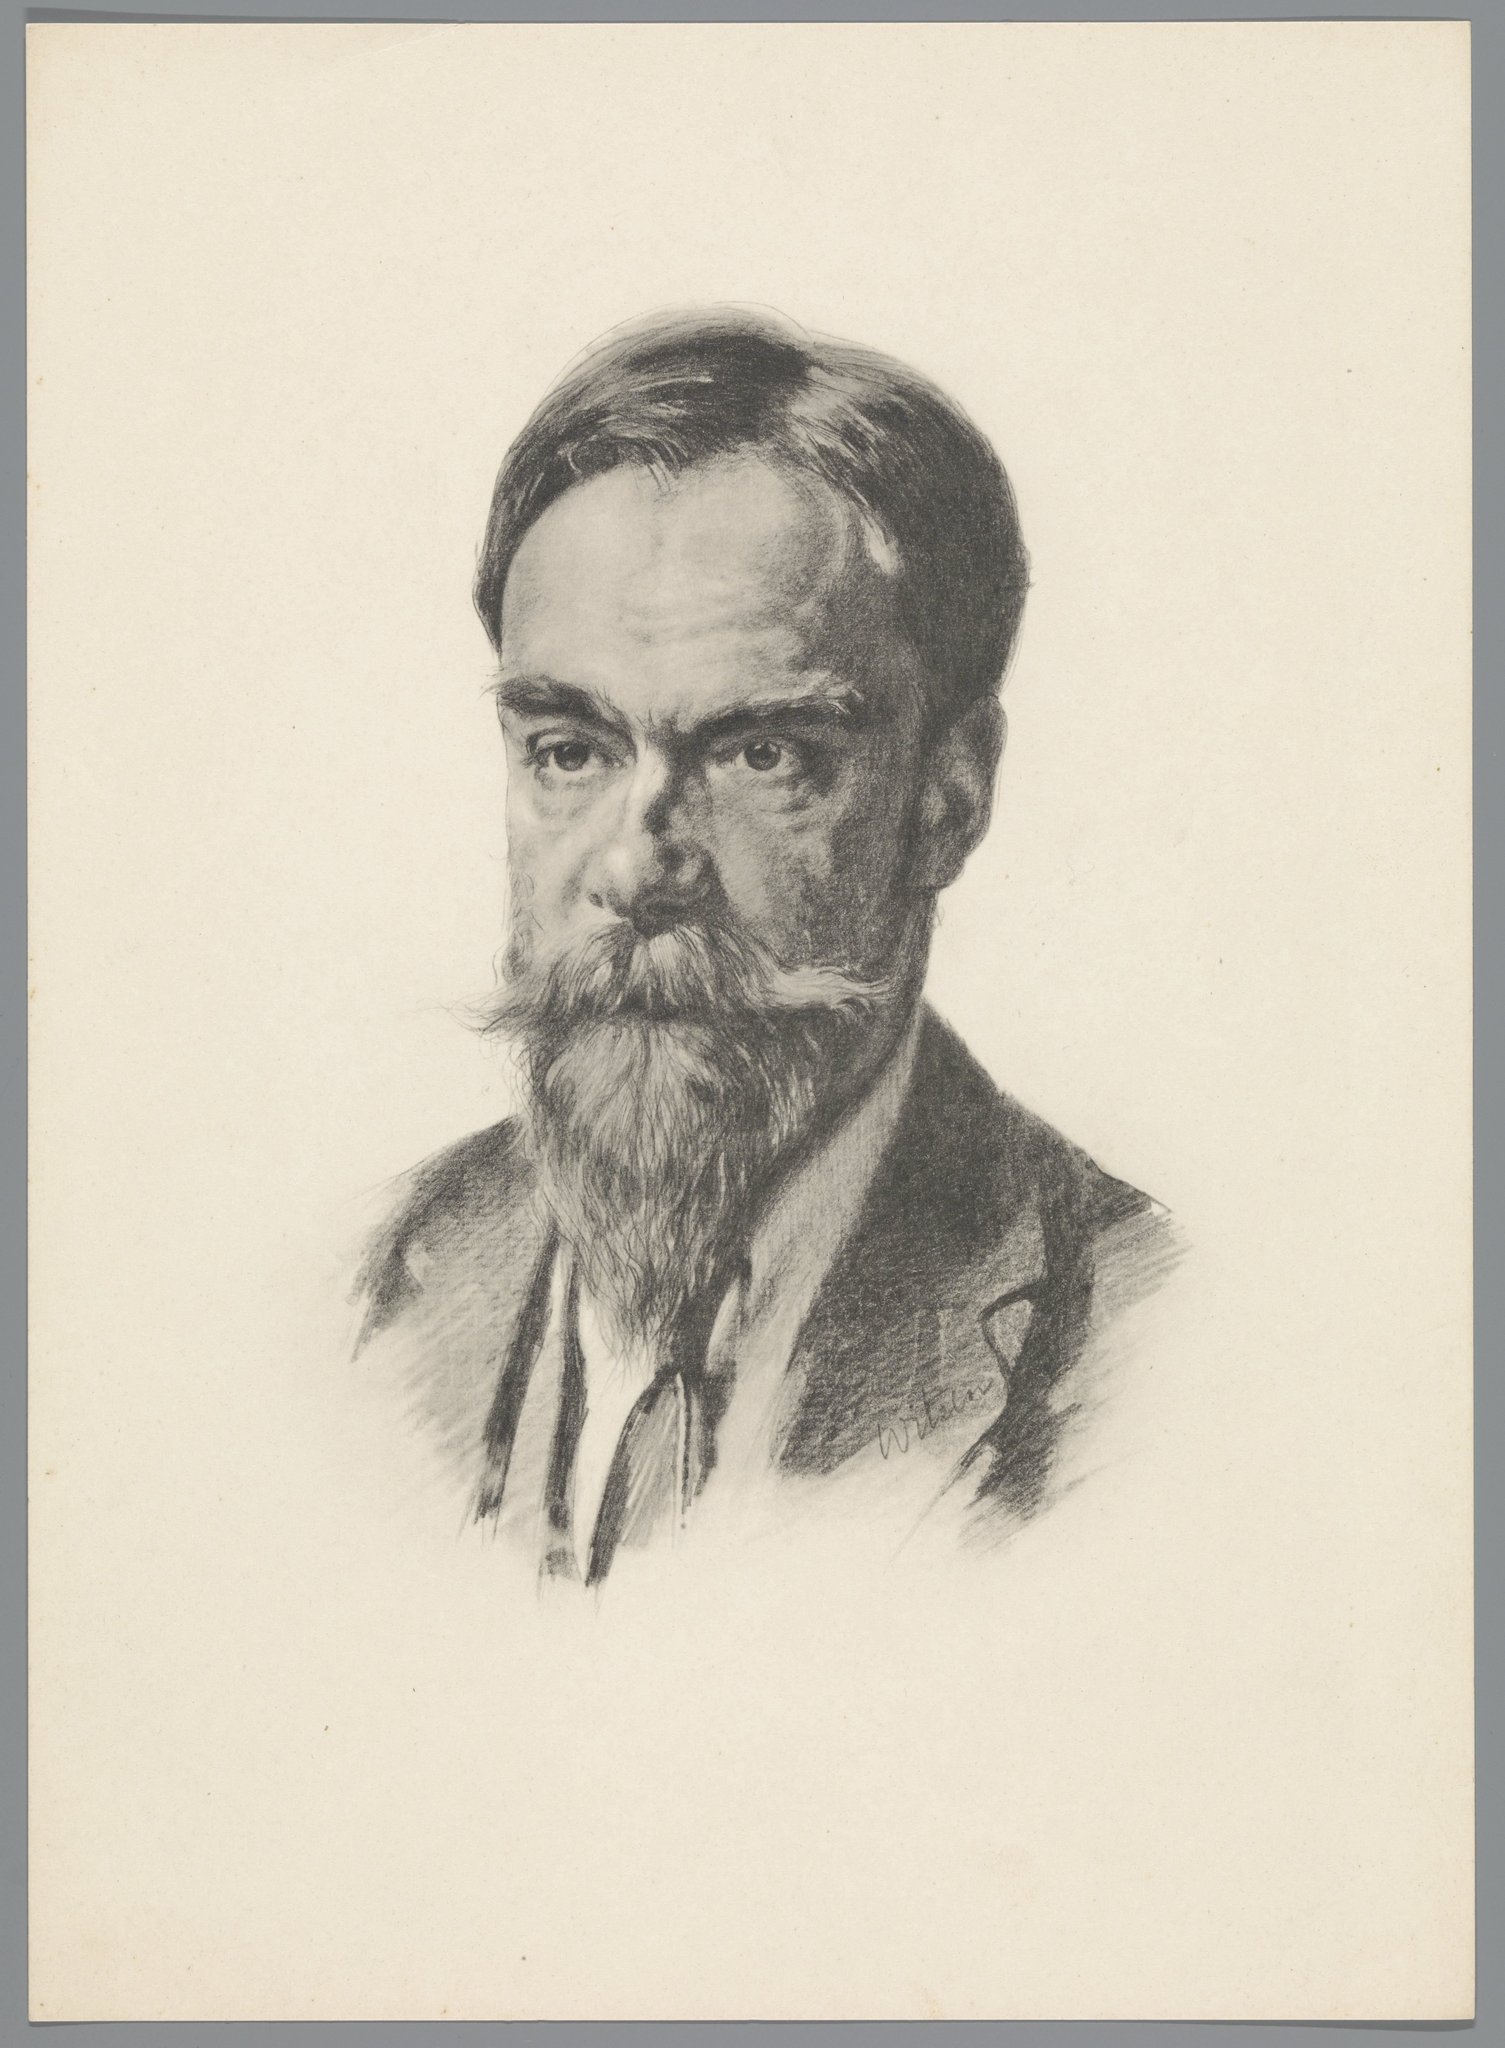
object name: print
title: Reproductie naar krijttekening met portret van Frans Coenen Jr.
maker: Anonymous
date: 1860-1915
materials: paper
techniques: photograph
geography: netherlands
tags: frans coenen (1866-1936)